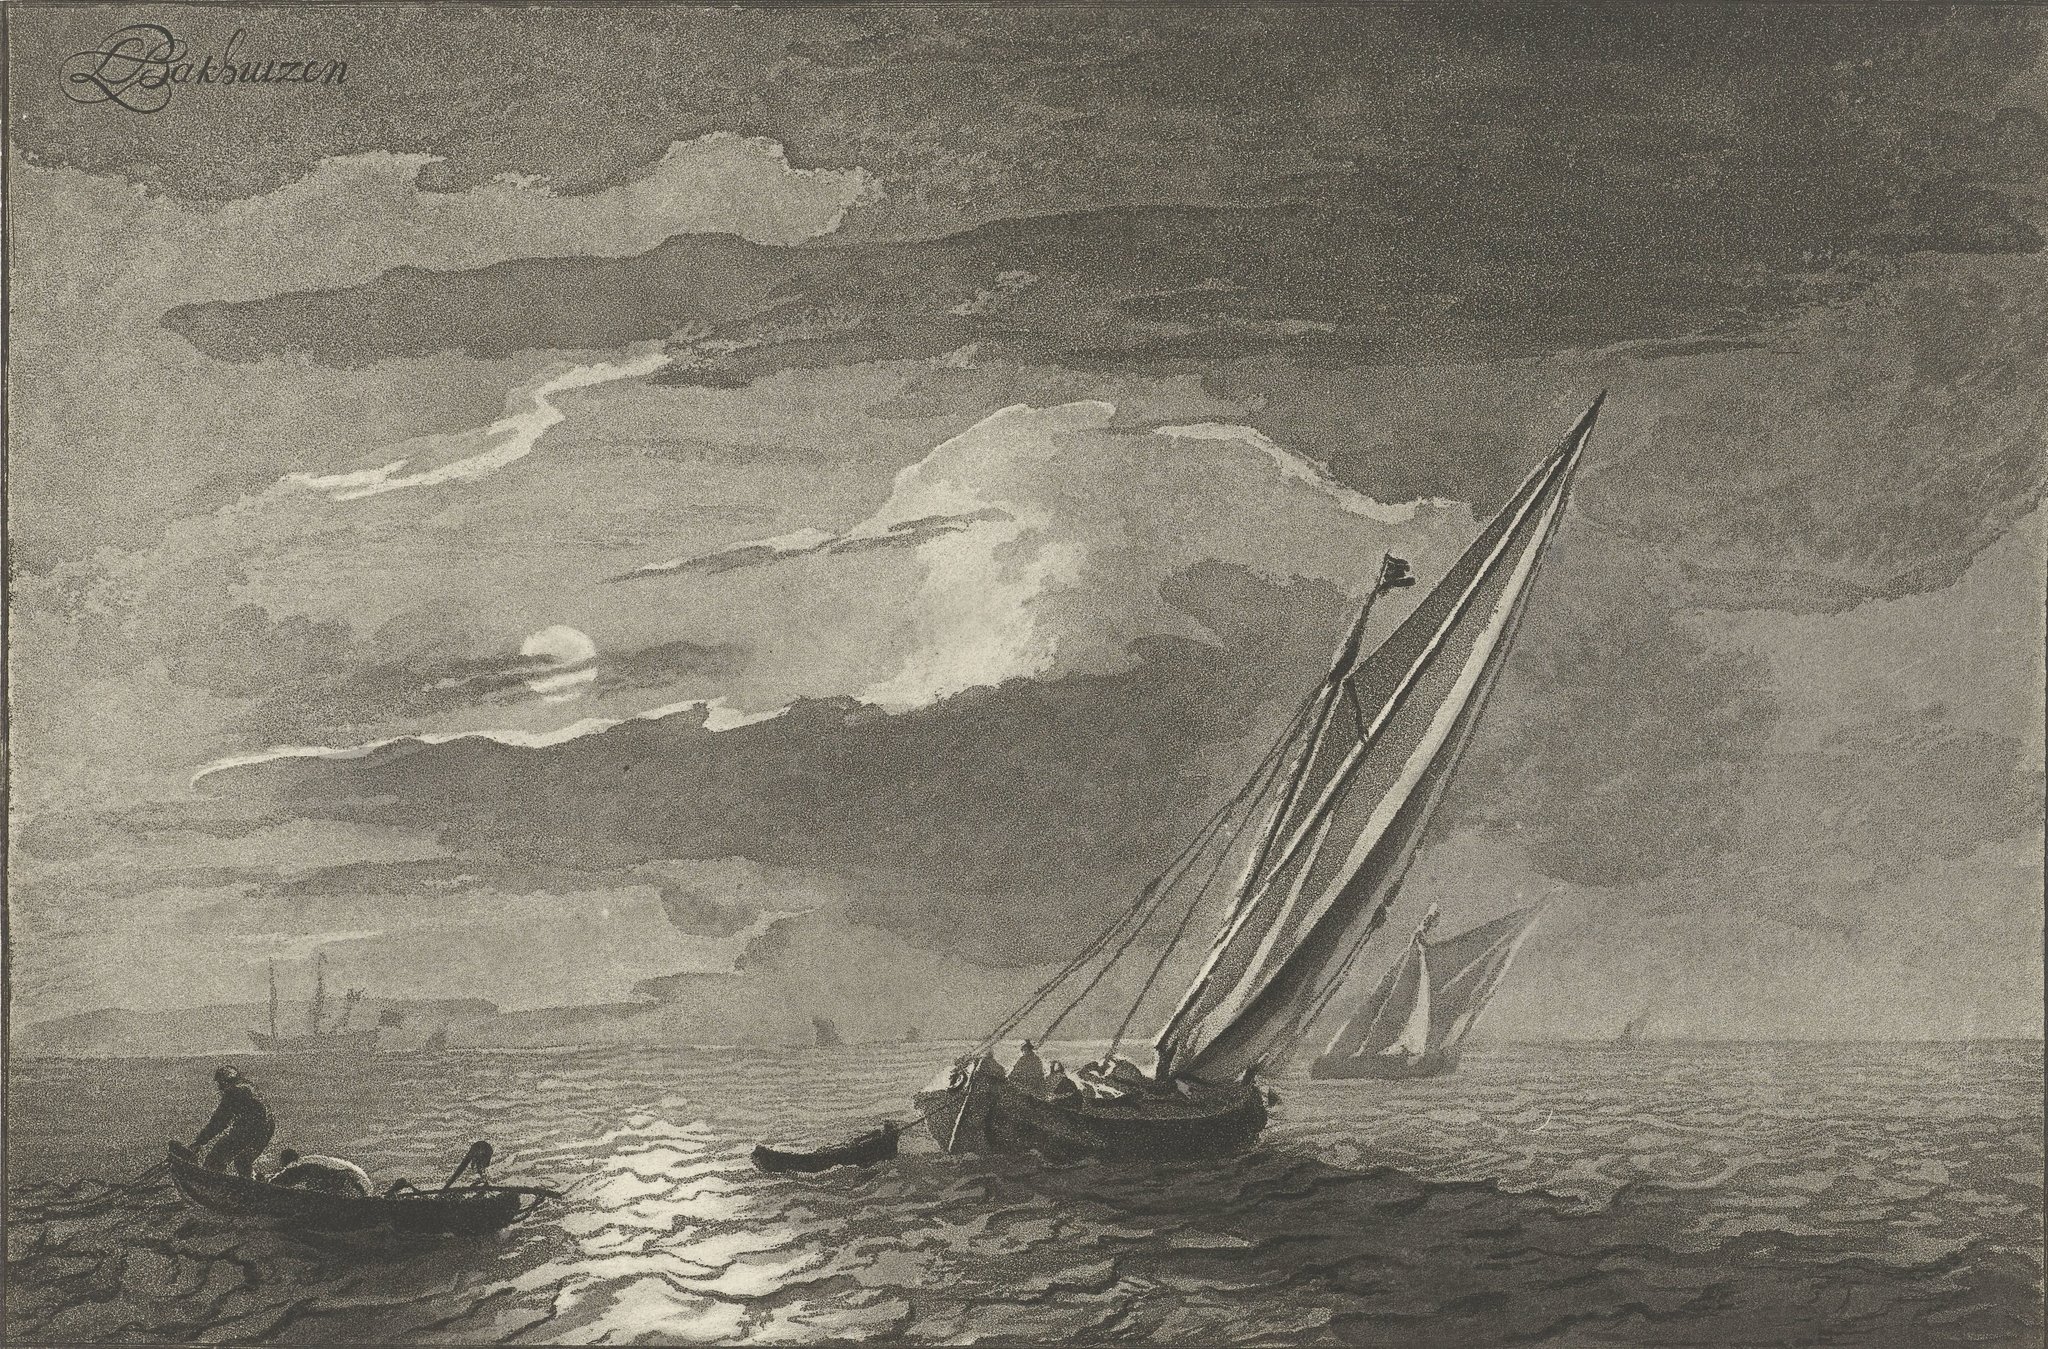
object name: print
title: Zeegezicht met volle maan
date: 1781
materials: paper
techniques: transfer, print drawing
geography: amsterdam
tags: sailing-ship, sailing-boat, moonlight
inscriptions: collector's mark: Lugt 2725, collector's mark: Lugt 240, inscription: ‘L. Bakhuizen del. Ploos van Amstel. J.C. Fecit: 1781.’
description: Op zee varen twee zeilschepen. Een visser haalt vanuit een sloep zijn netten binnen.